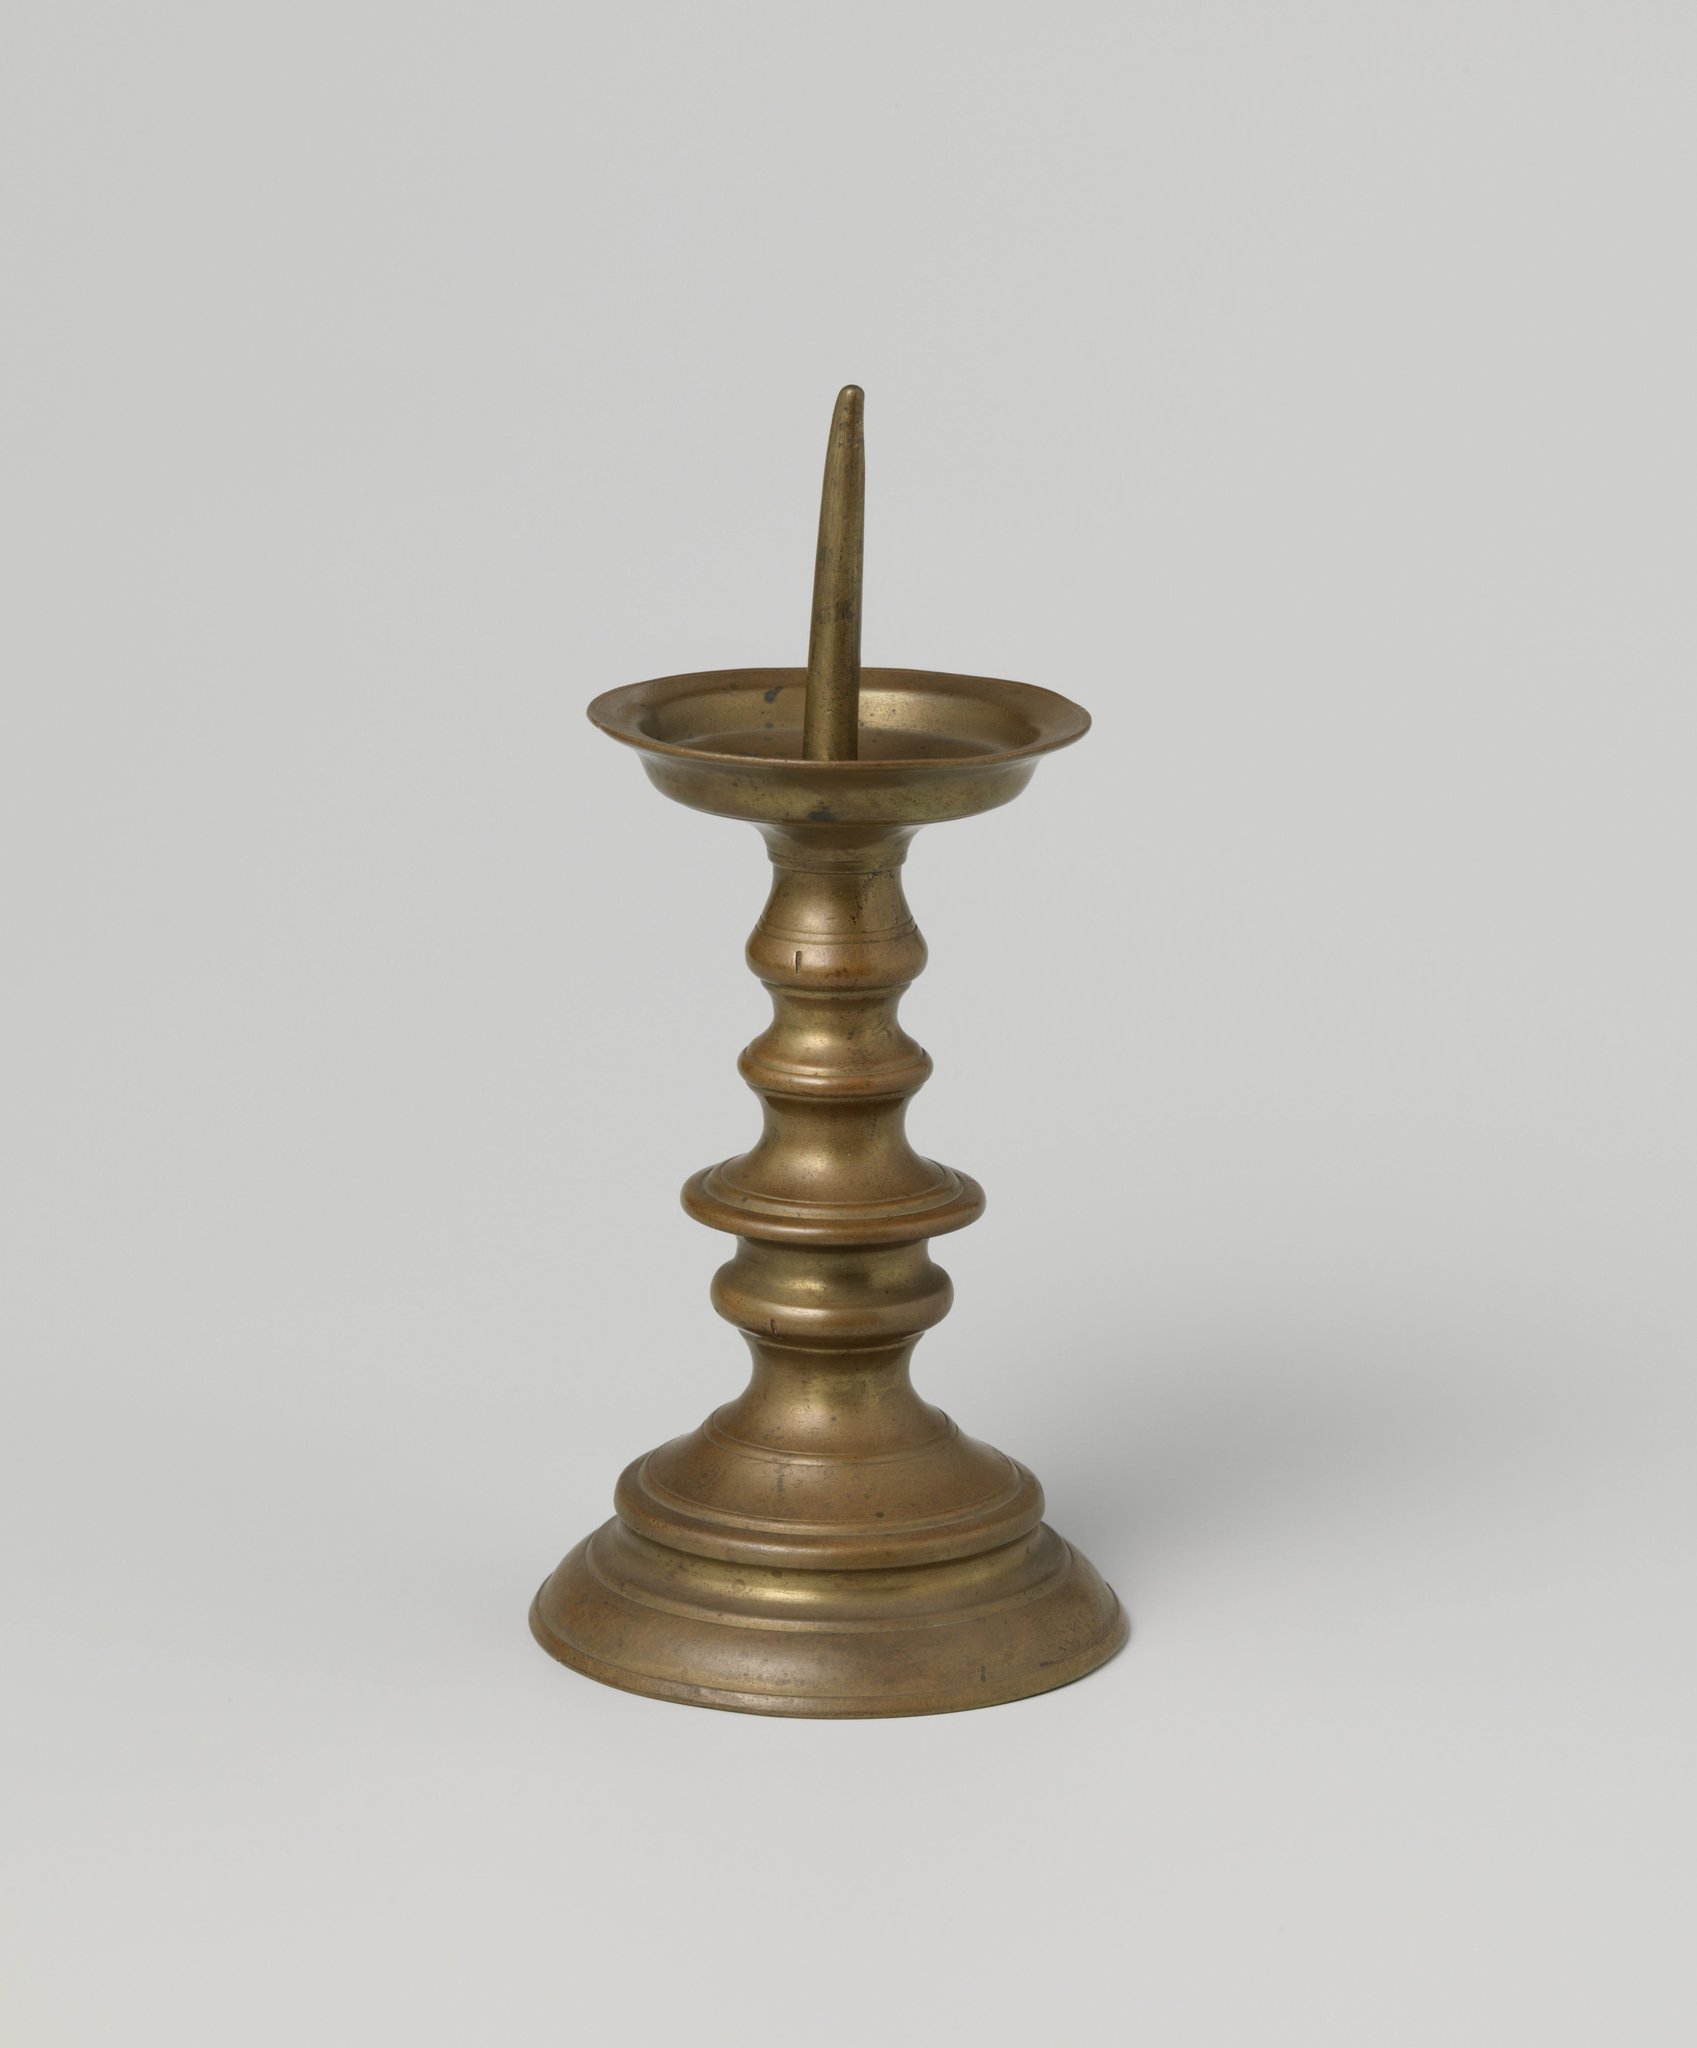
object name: candlestick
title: Kandelaar met geprofileerde stam en voet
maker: Anonymous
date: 1500-1600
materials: brass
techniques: casting, soldering, turning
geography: southern germany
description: De ronde geprofileerde voet gaat over in een overwegend holrond geprofileerde stam en vervolgens in een vetvanger, waarop de kaarsenpin is gesoldeerd. Voet, stam en vetvanger, die als één geheel zijn gegoten, zijn voorzien van gegroefde ringen. De holle stam bevat nog resten van de zaadkern.